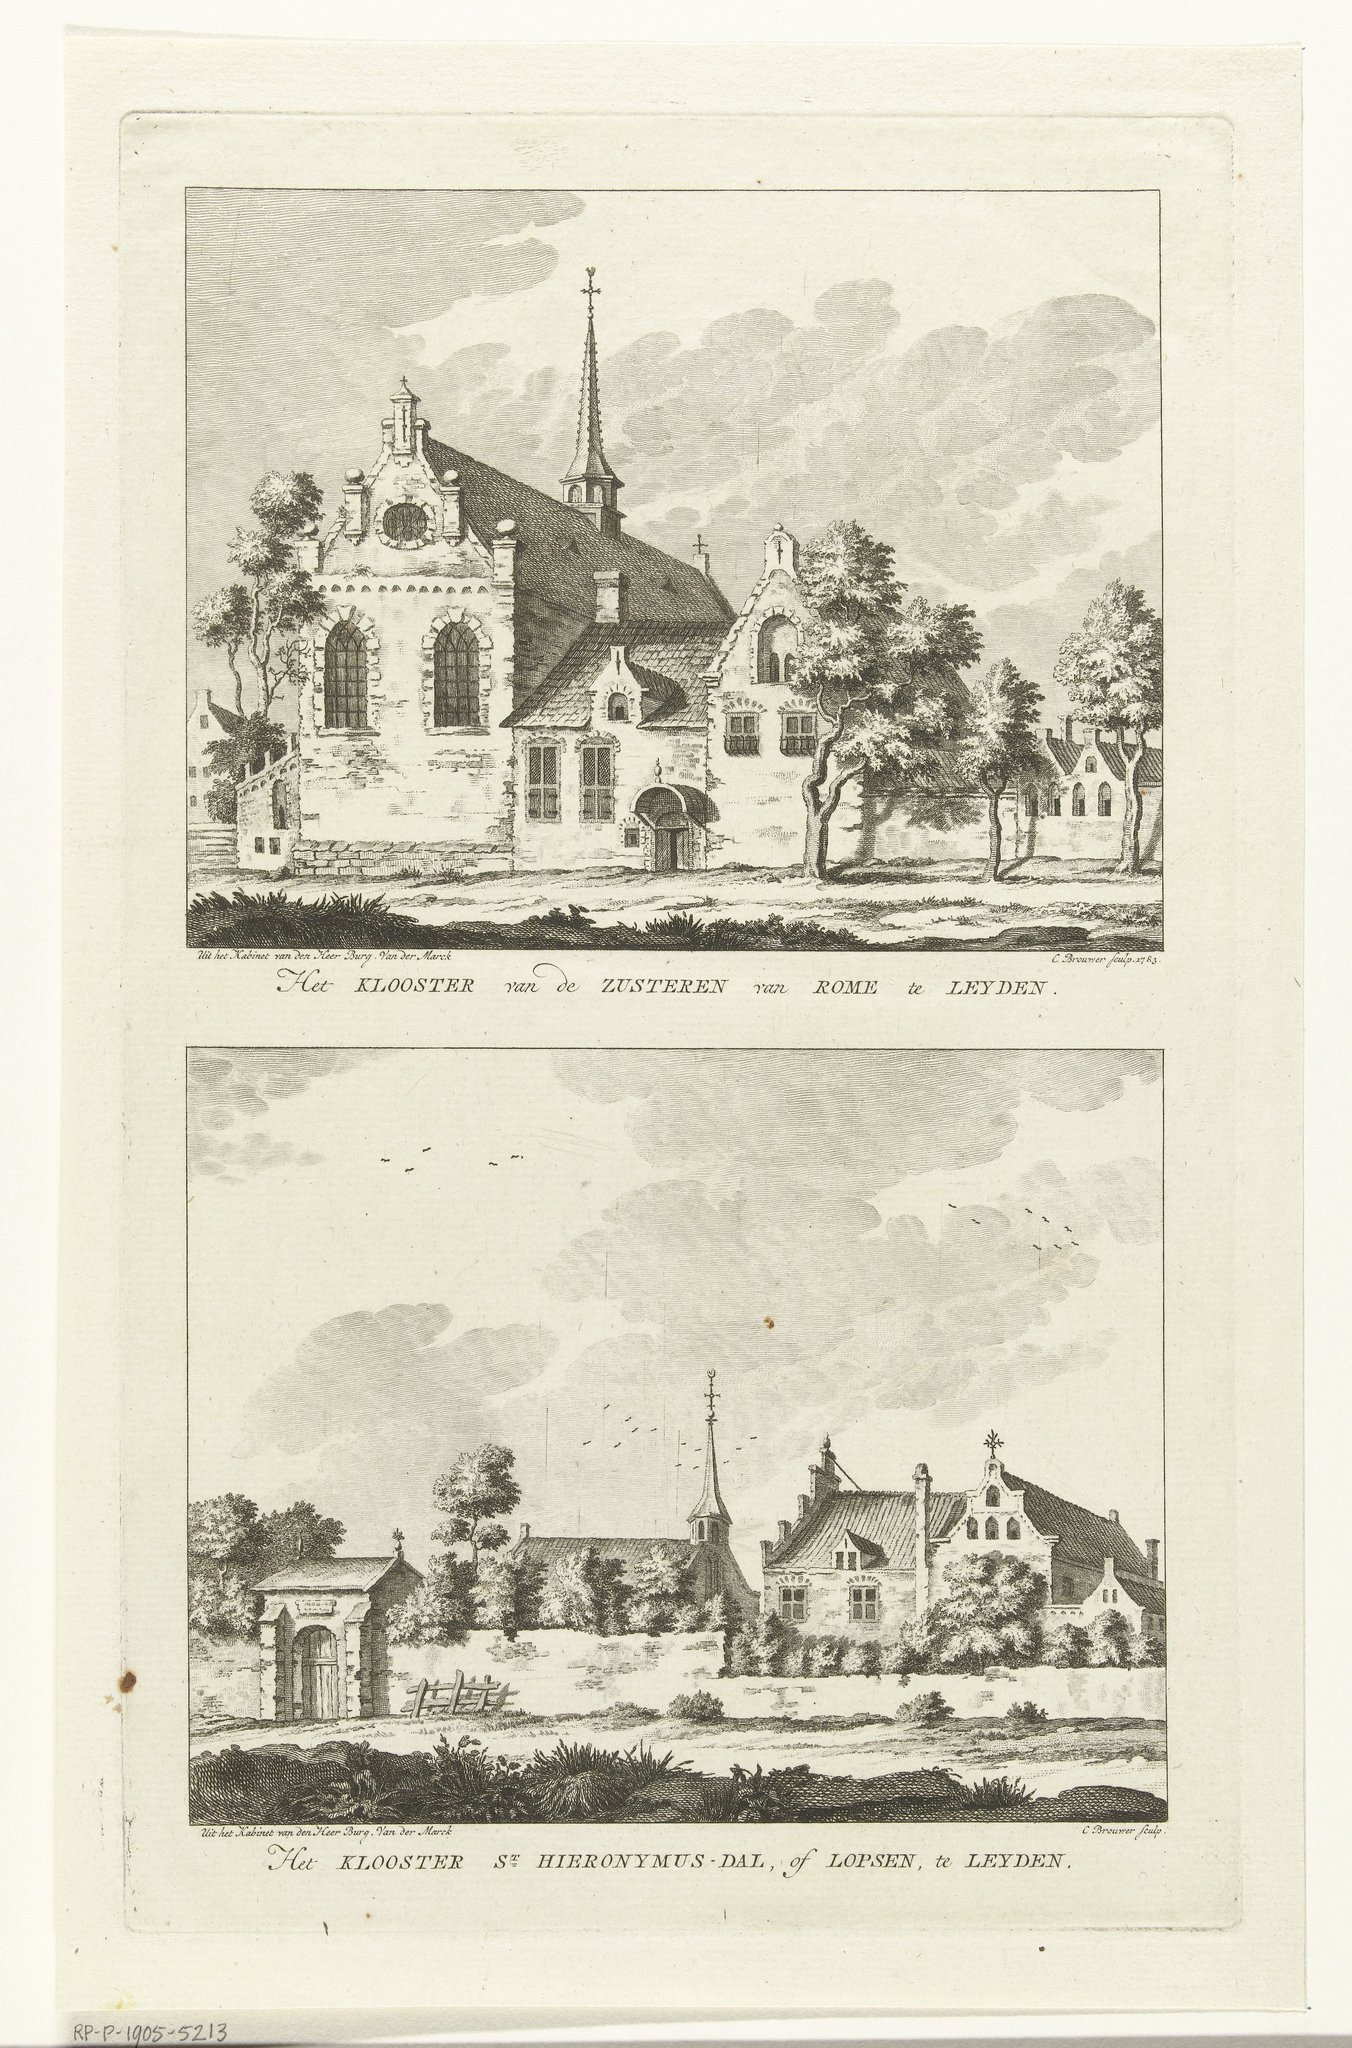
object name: print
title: Het klooster van de zusteren van Rome te Leyden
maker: cornelis brouwer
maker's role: print maker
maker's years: 1731-1803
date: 1783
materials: paper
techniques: etching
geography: netherlands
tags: abbey, monastery, convent ~ roman catholic church, leiden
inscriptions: collector's mark: Lugt 2228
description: Prent naar tekeningen welke zich bevonden in de verzameling van burgemeester Van der Marck aldus het opschrift onder de voorstellingen. Prent voor onbekende uitgave. Vergelijk een tekening van Jacobus Stellingwerff in de collectie van het Regionaal Archief Leiden met een zeer vergelijkbaar gezicht op het klooster Sint-Hiëronymusdal of de Lopsen.